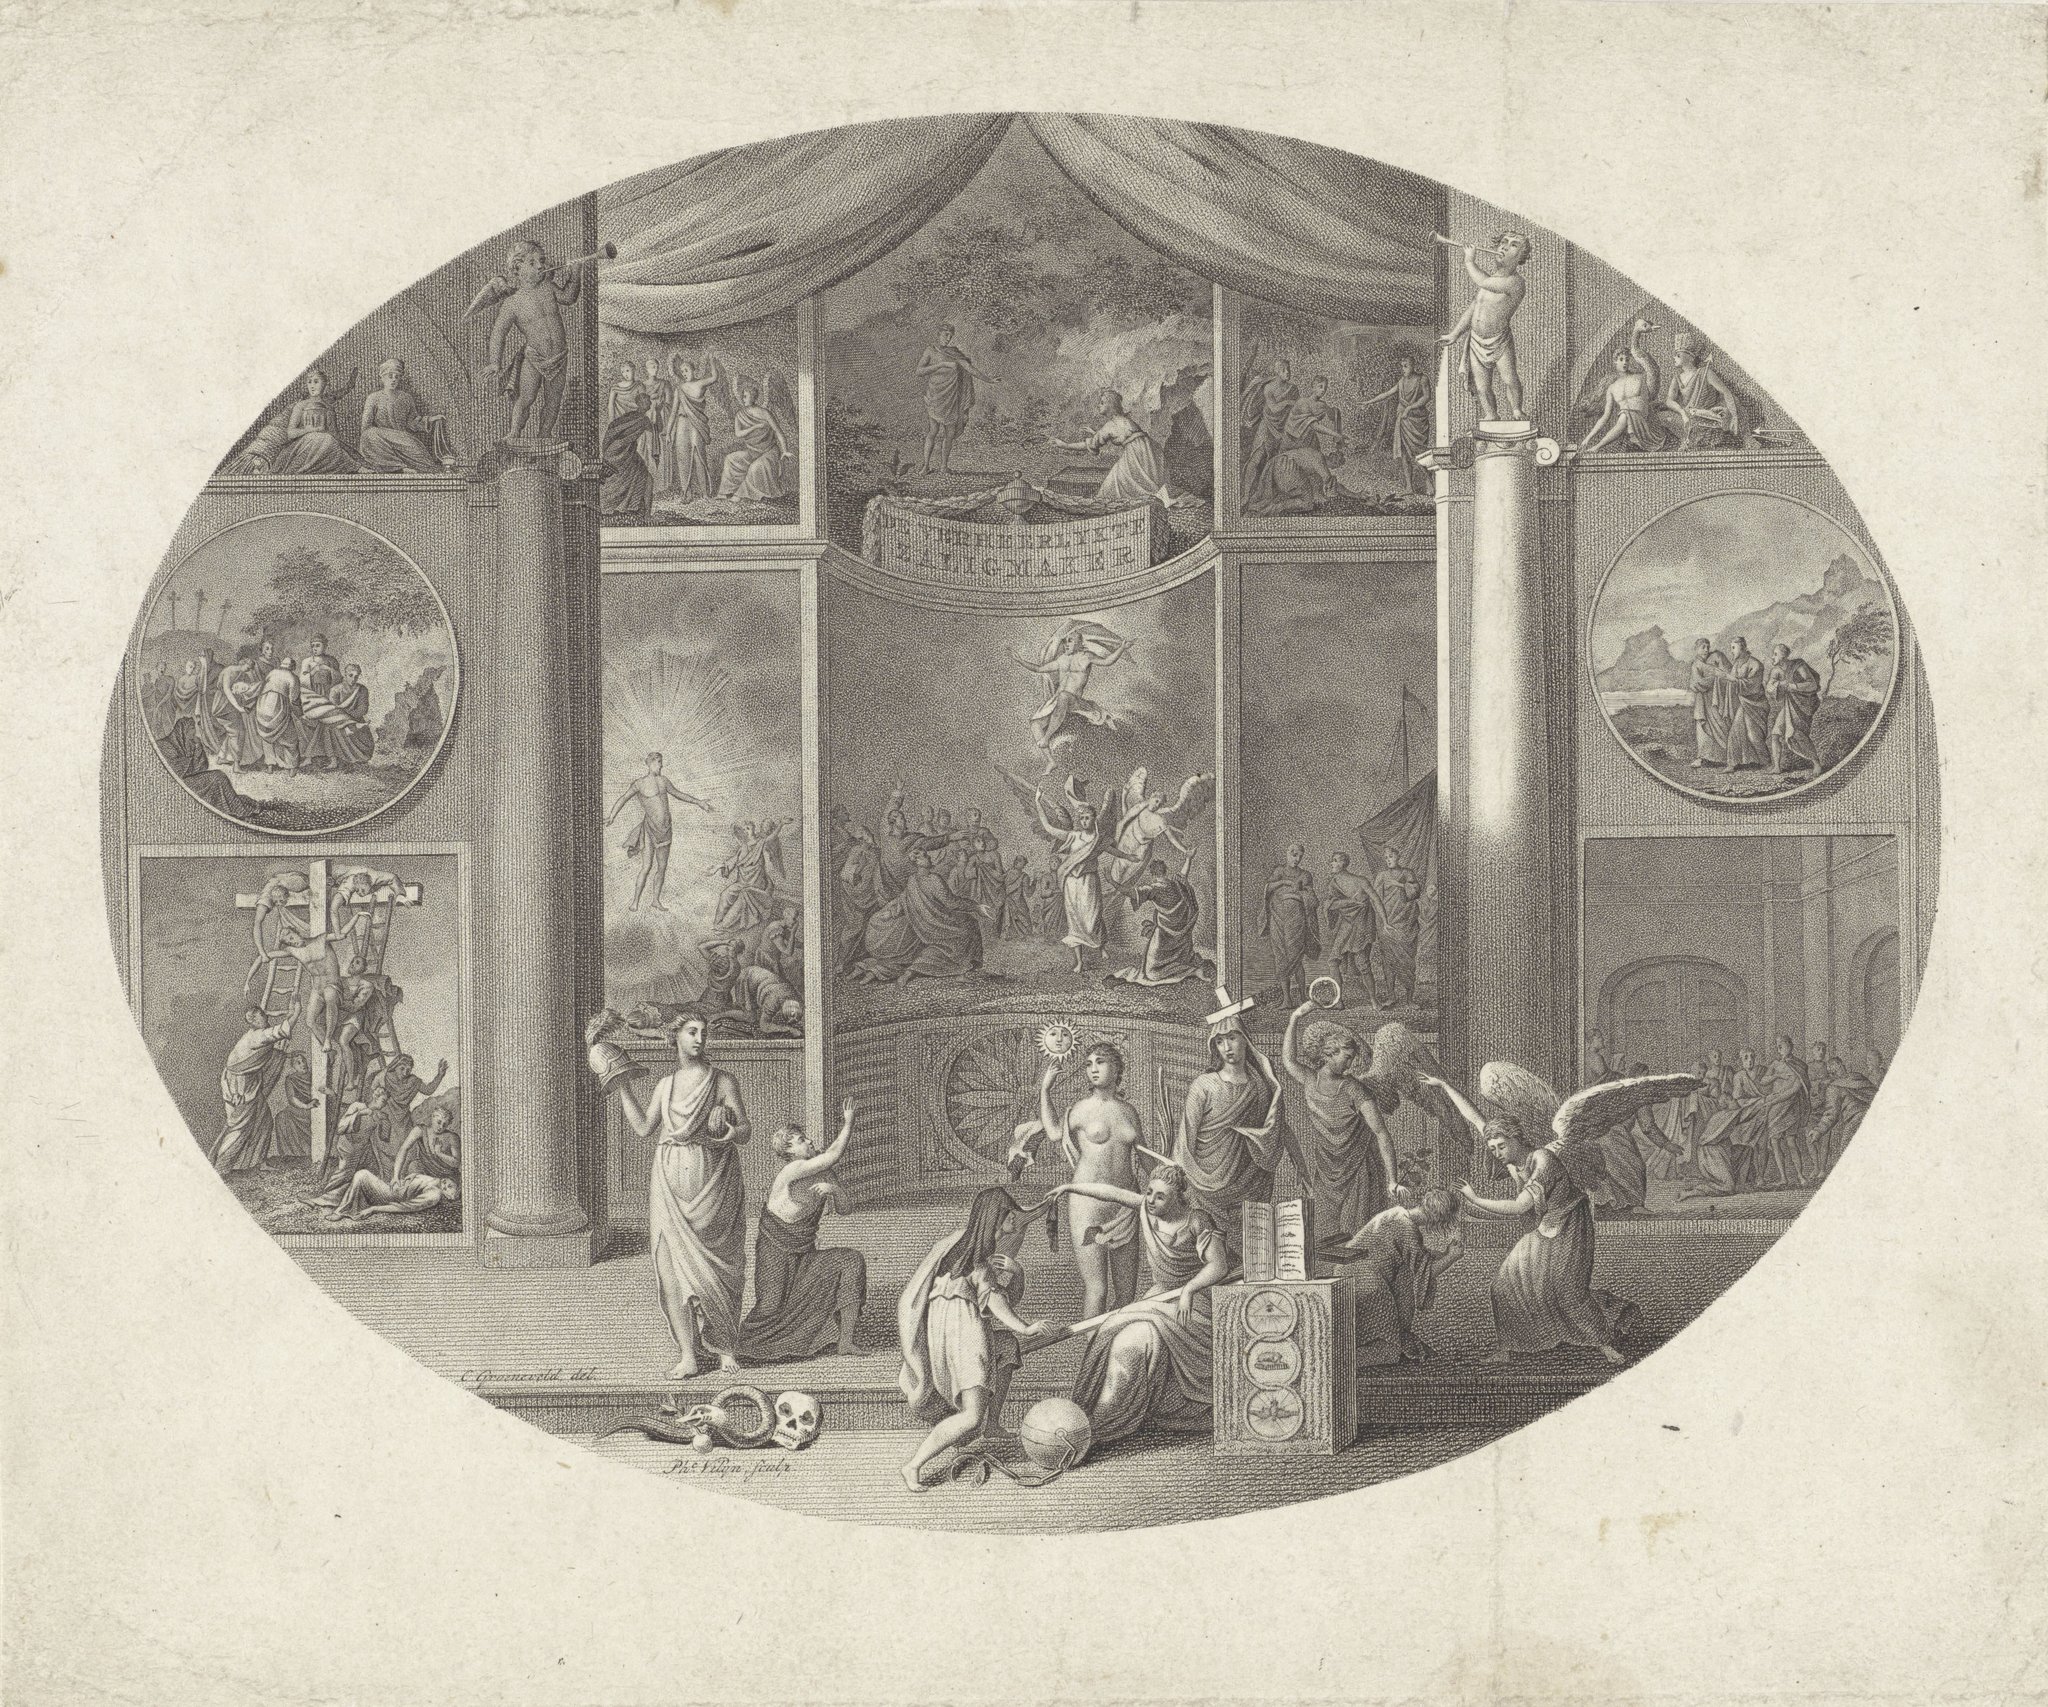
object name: print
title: Religieuze allegorische voorstelling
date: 1797-1836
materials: paper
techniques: engraving, etching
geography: netherlands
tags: three interlocked circles ~ trinity, allegorical representations ~ religion; 'religione', 'religione de ss. mauritio e lazaro', 'religione vera christiana' (ripa), series of scenes from the life of christ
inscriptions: collector's mark: Lugt 2228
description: Een religieuze allegorische voorstelling in een interieur met zuilen en een façade met scènes uit het leven van Christus. Op de voorgrond verschillende allegorische figuren en twee engelen bij een zuil waarop drie ringen met het Alziend Oog, het Lam en de Heilige Geest in de gedaante van een duif. Links op de voorgrond de slang met de appel van de boom der kennis van goed en kwaad naast een schedel.